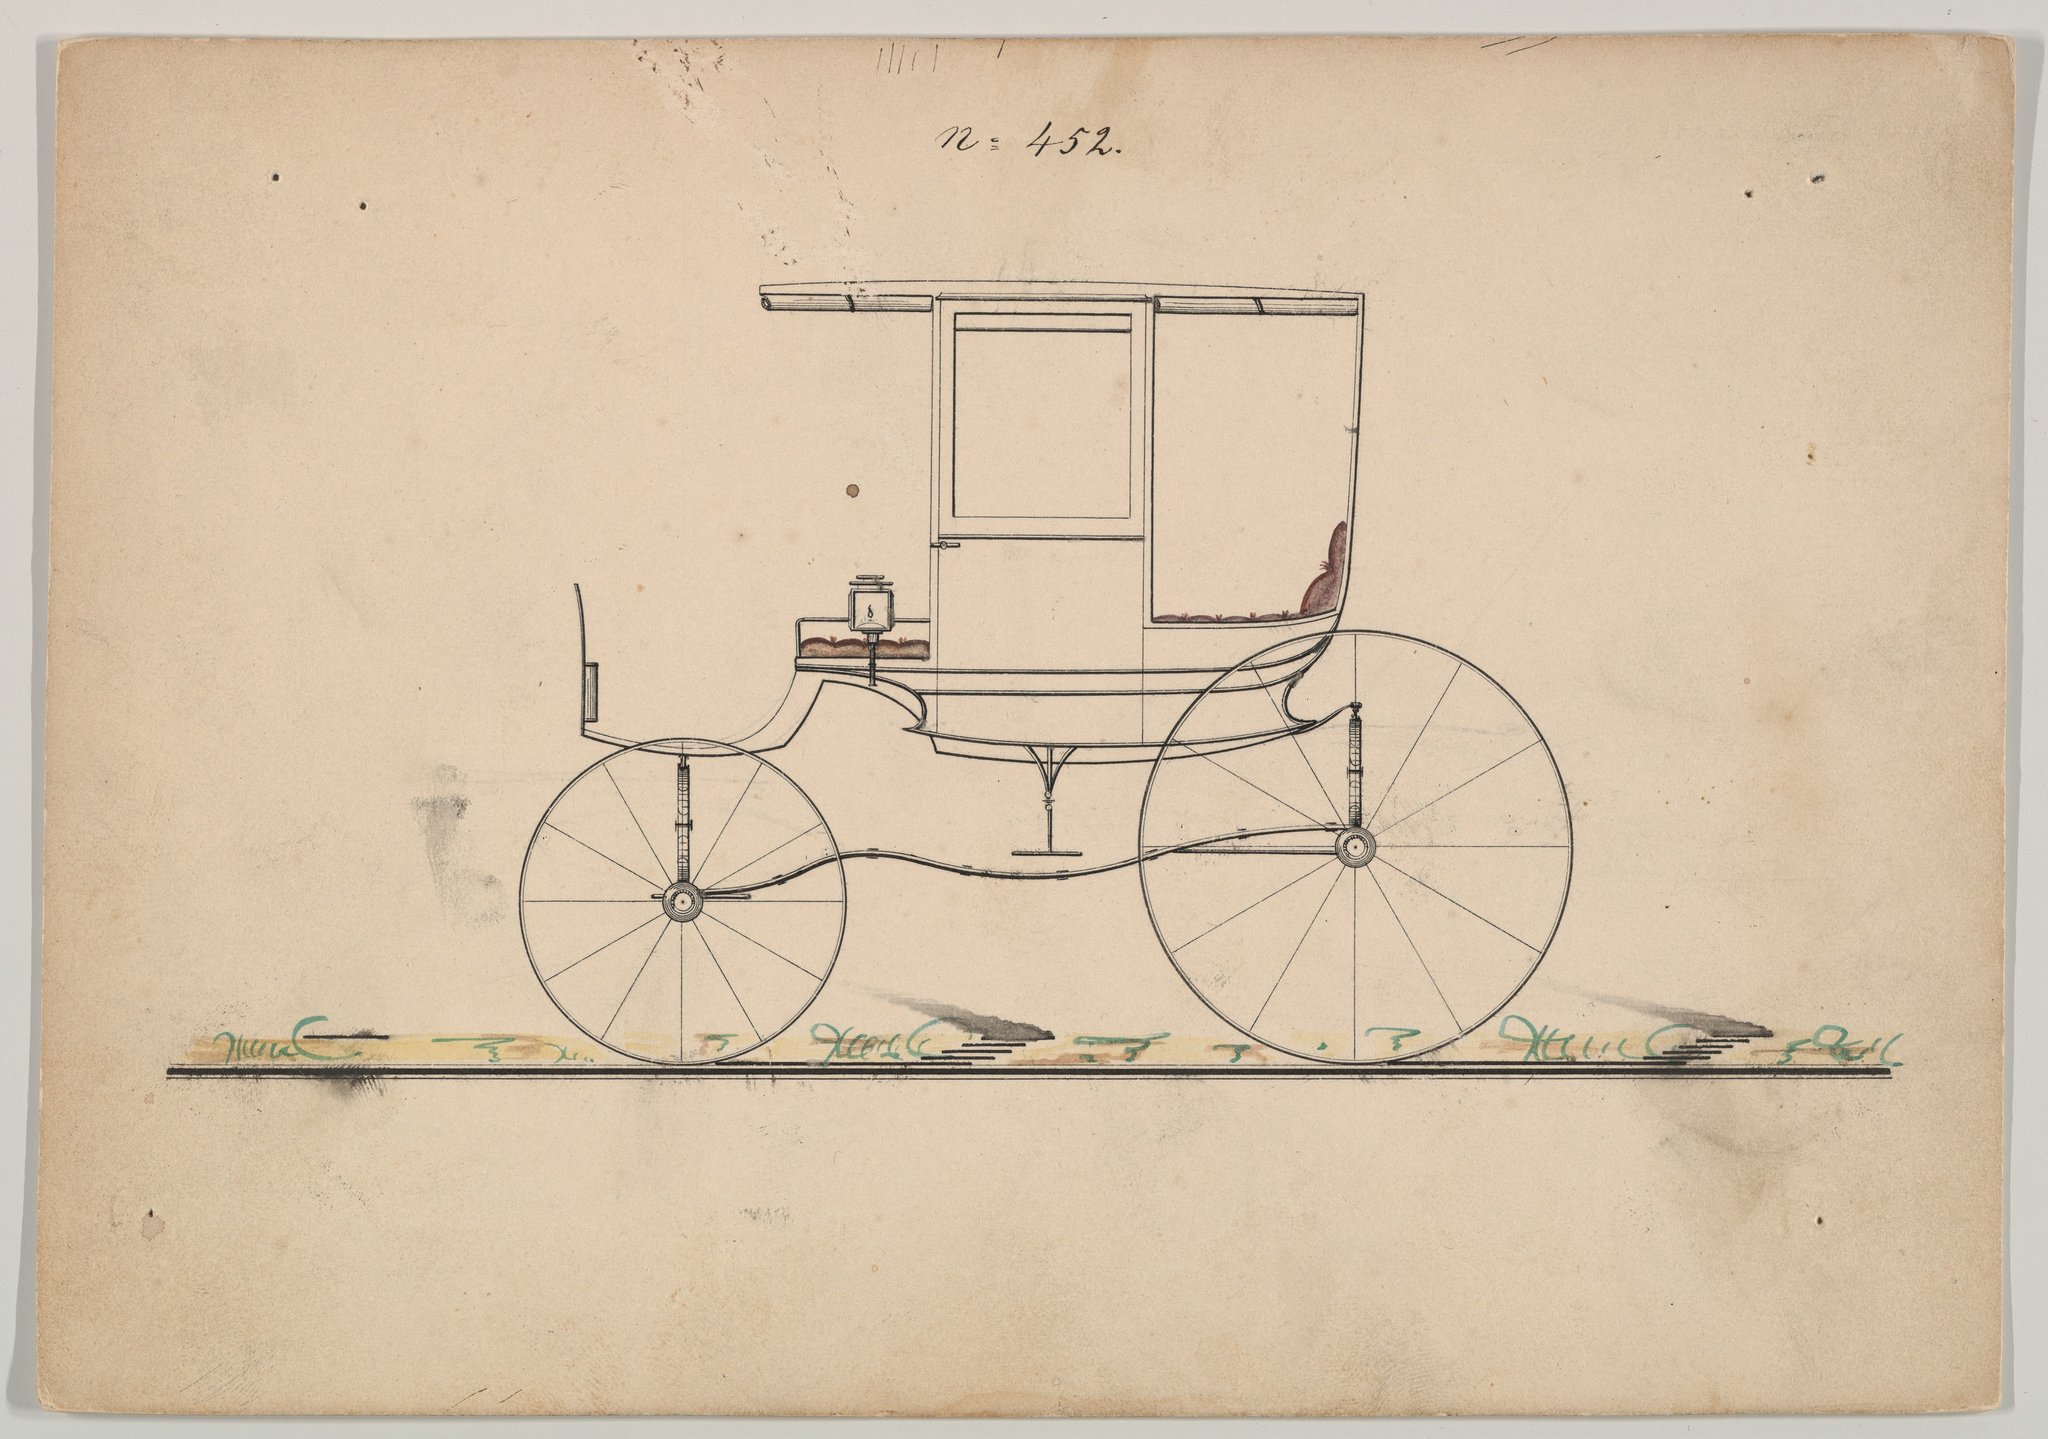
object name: drawing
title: Design for Rockaway, no. 452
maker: brewster & co.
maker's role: manufacturer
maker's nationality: american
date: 1860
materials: ink, watercolor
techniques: pen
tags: carriages